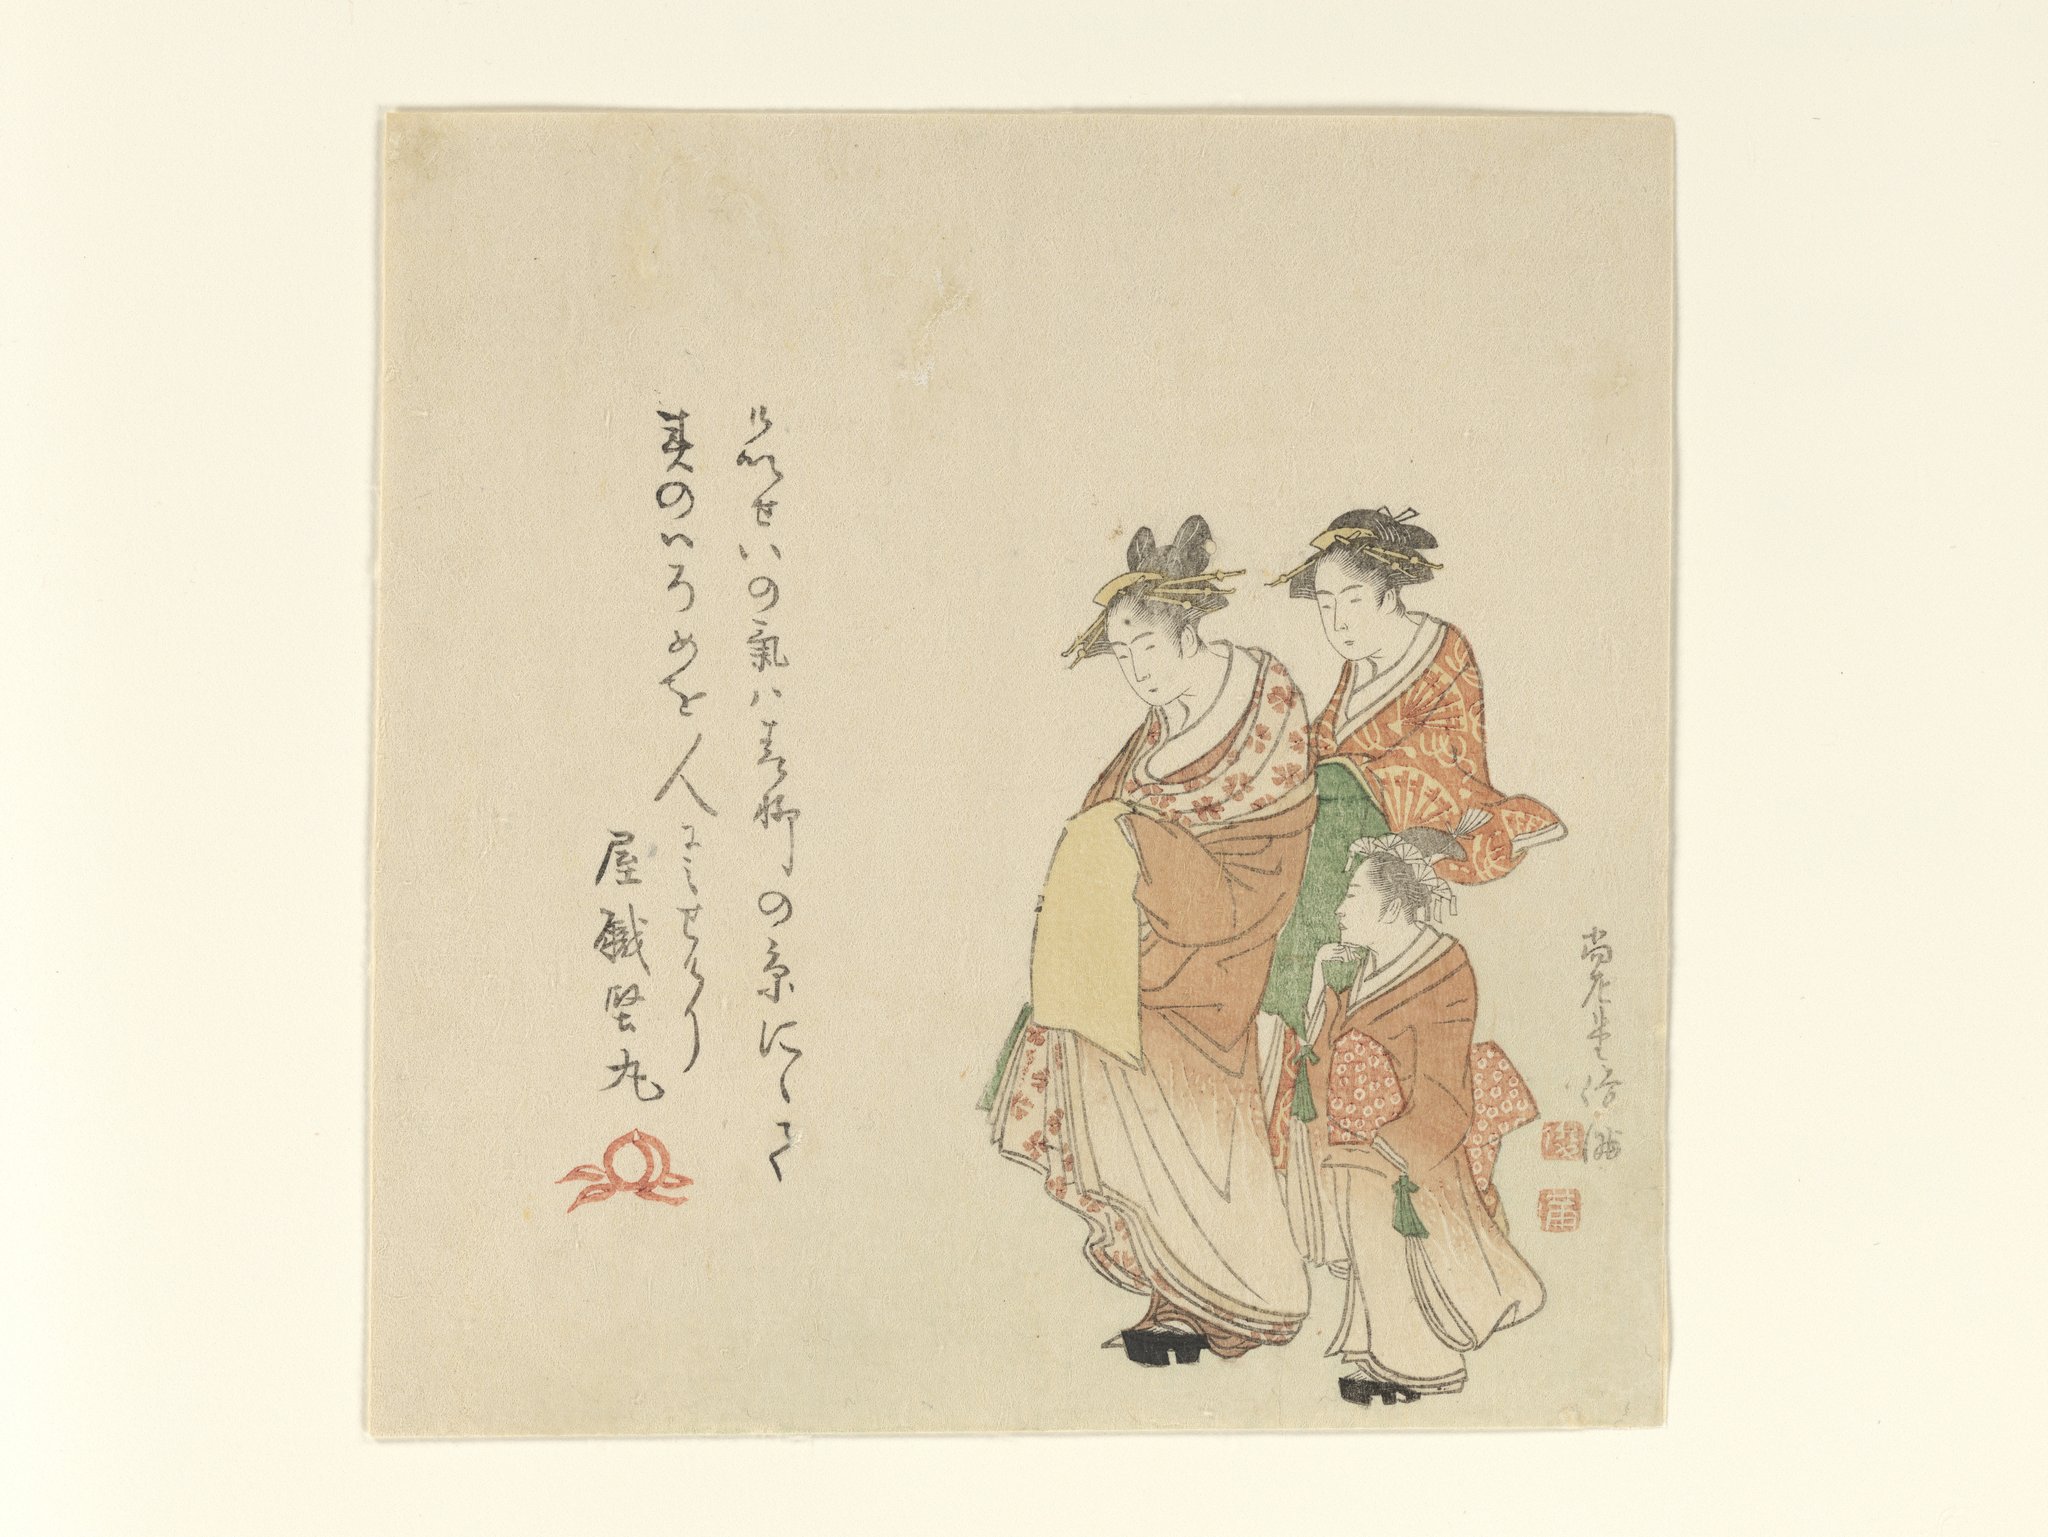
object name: print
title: Courtesan with Two Attendants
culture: japanese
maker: kubo shunman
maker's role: artist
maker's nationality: japanese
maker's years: 1757-1820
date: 1797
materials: ink, paper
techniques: surimono, woodblock print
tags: women